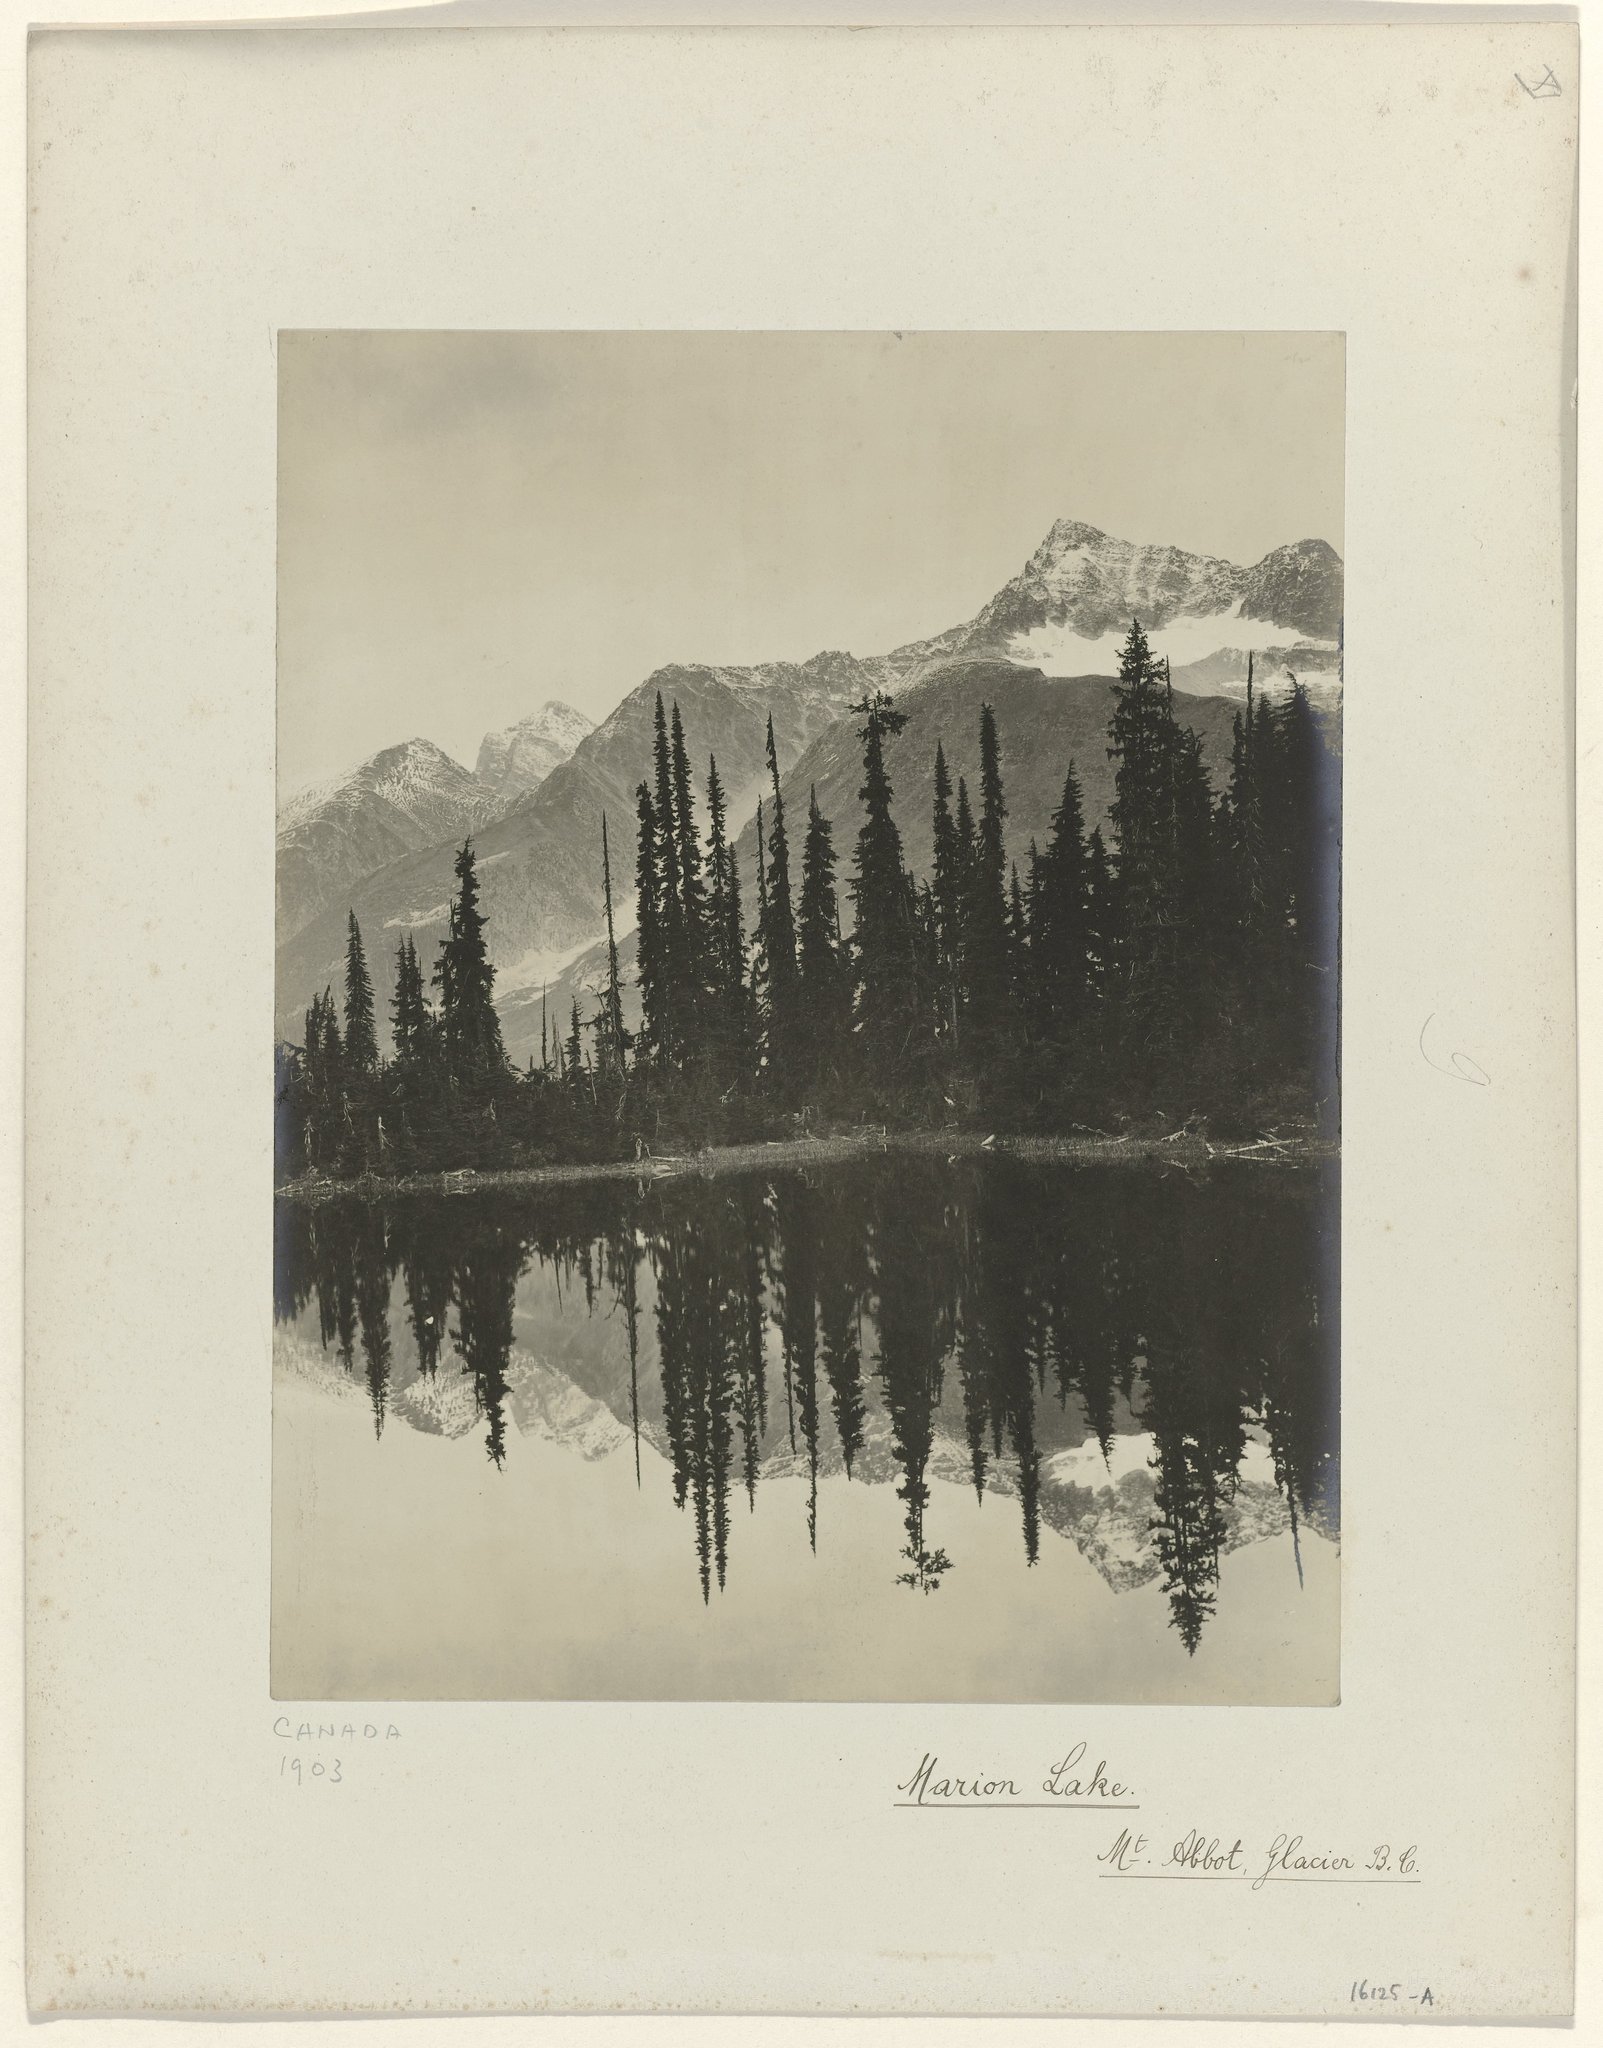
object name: photograph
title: Gezicht op Marion Lake en Mount Abbot in Brits-Columbia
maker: william mcfarlane notman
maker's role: fotograaf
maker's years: -1913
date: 1903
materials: paper, cardboard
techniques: gelatin silver print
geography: british columbia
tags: lake, mountains